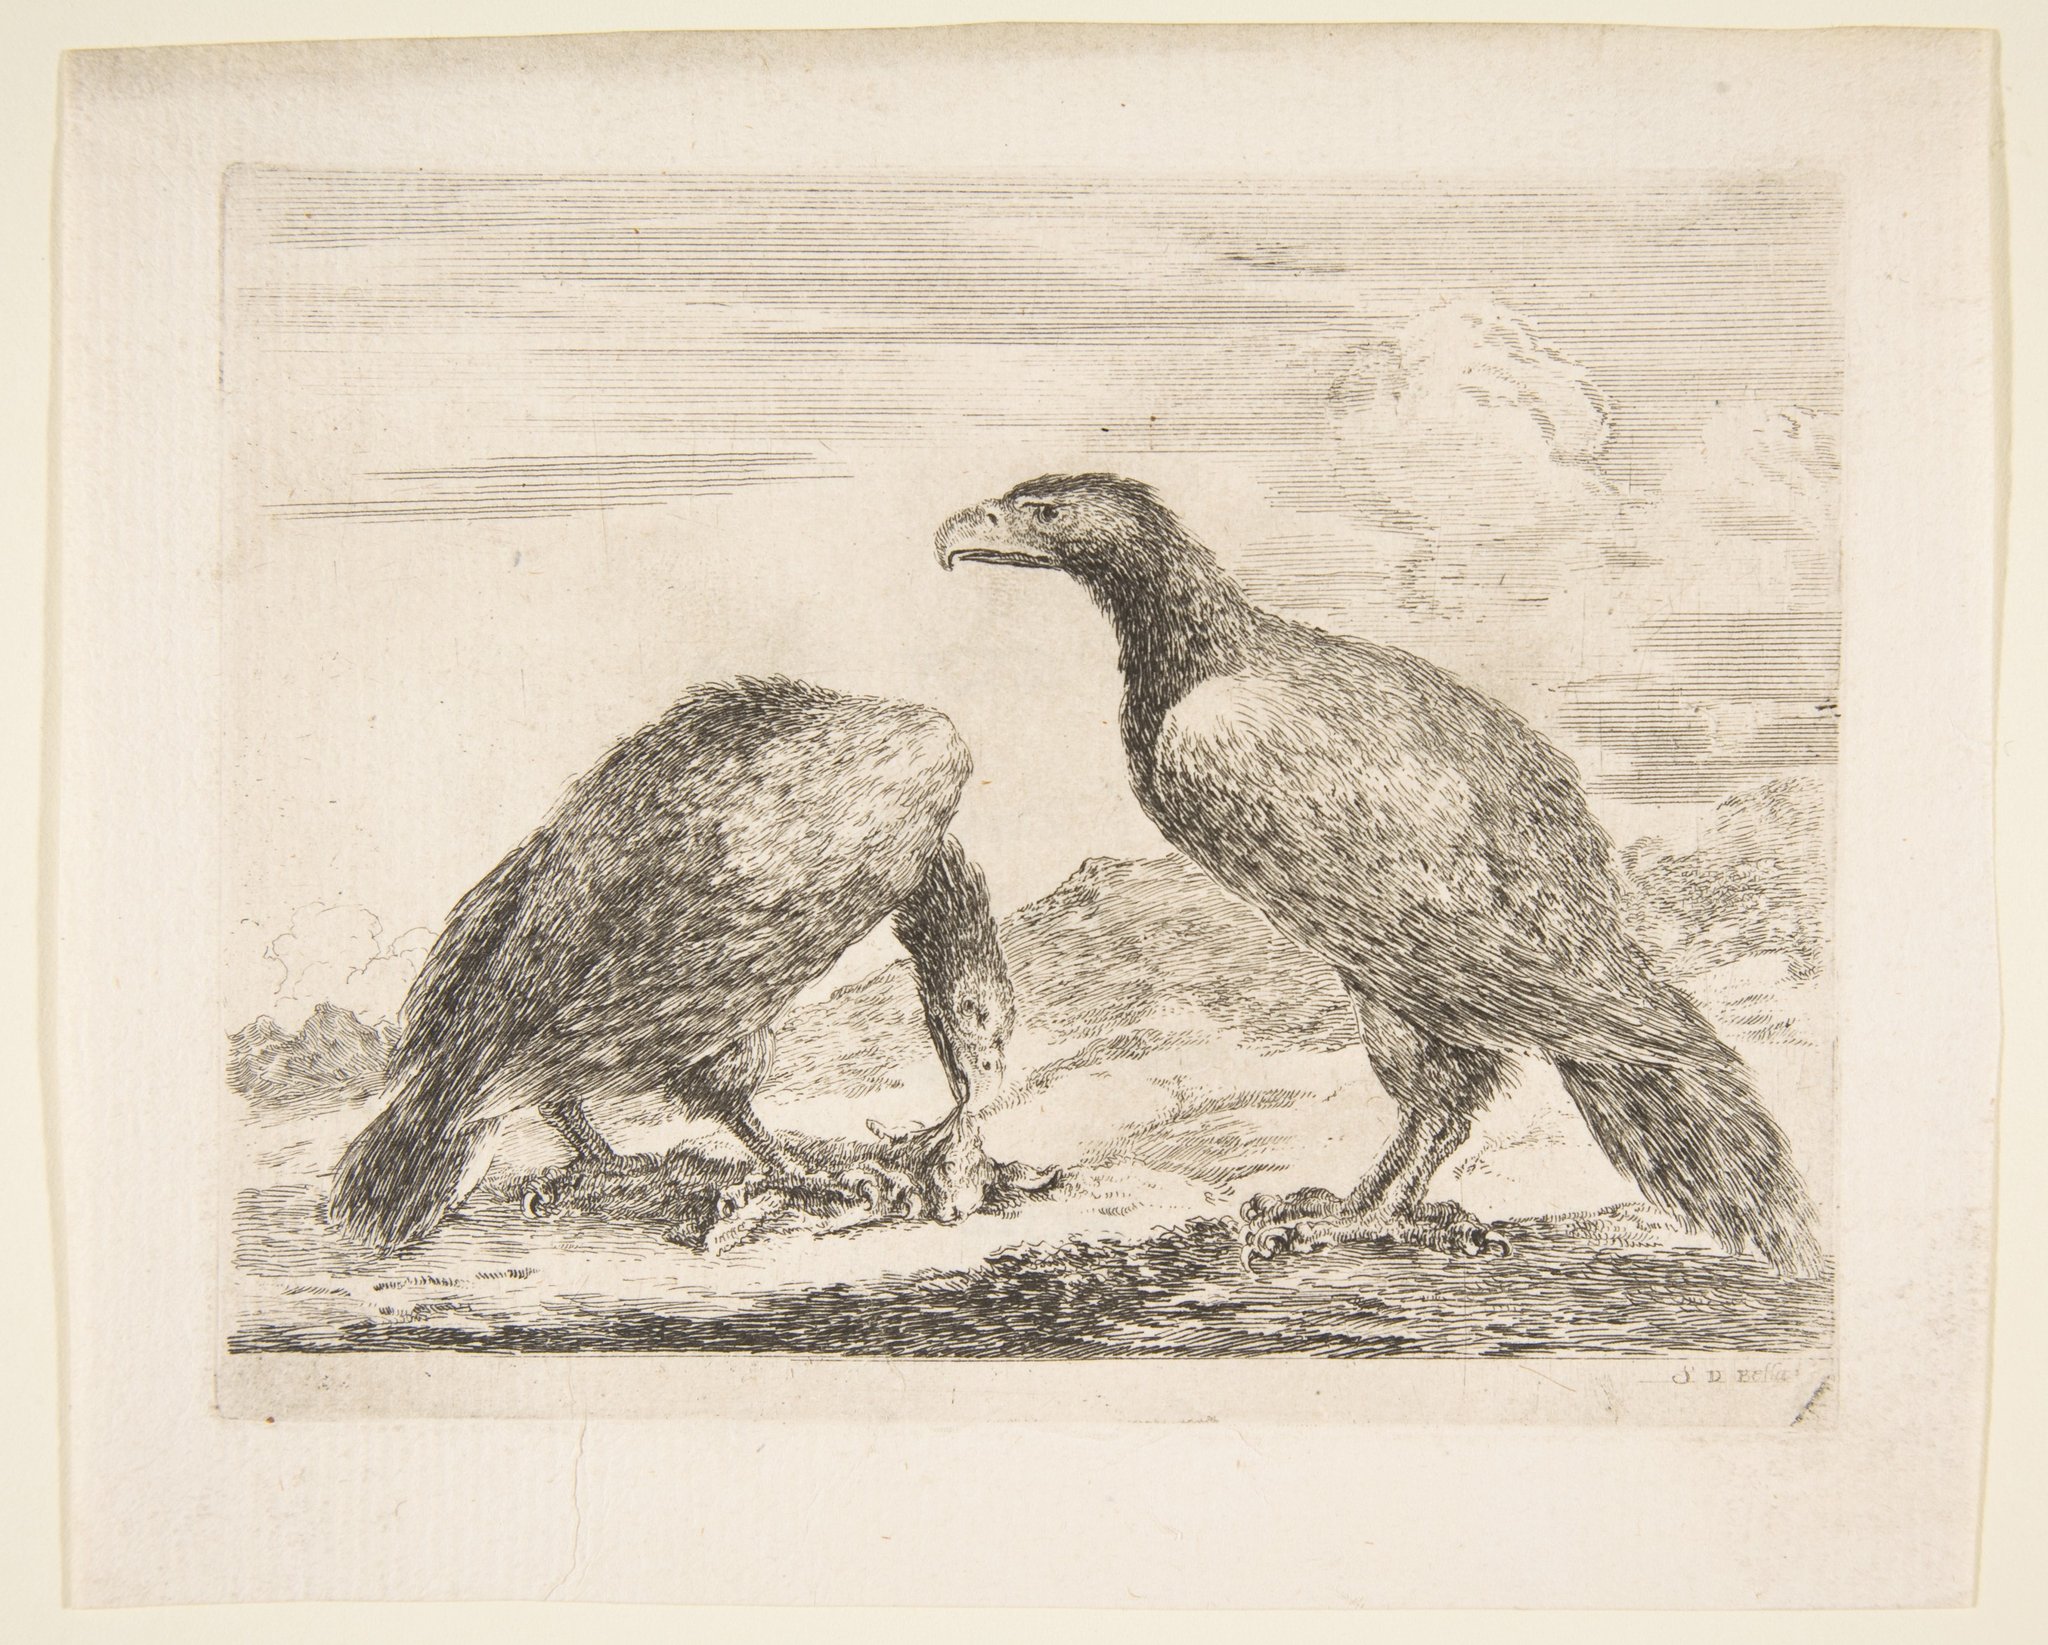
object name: print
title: Two eagles, one devouring a lamb, from 'Eagles' (Les aigles)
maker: stefano della bella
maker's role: artist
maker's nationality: italian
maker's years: 1610-1664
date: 1651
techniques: etching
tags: eagles